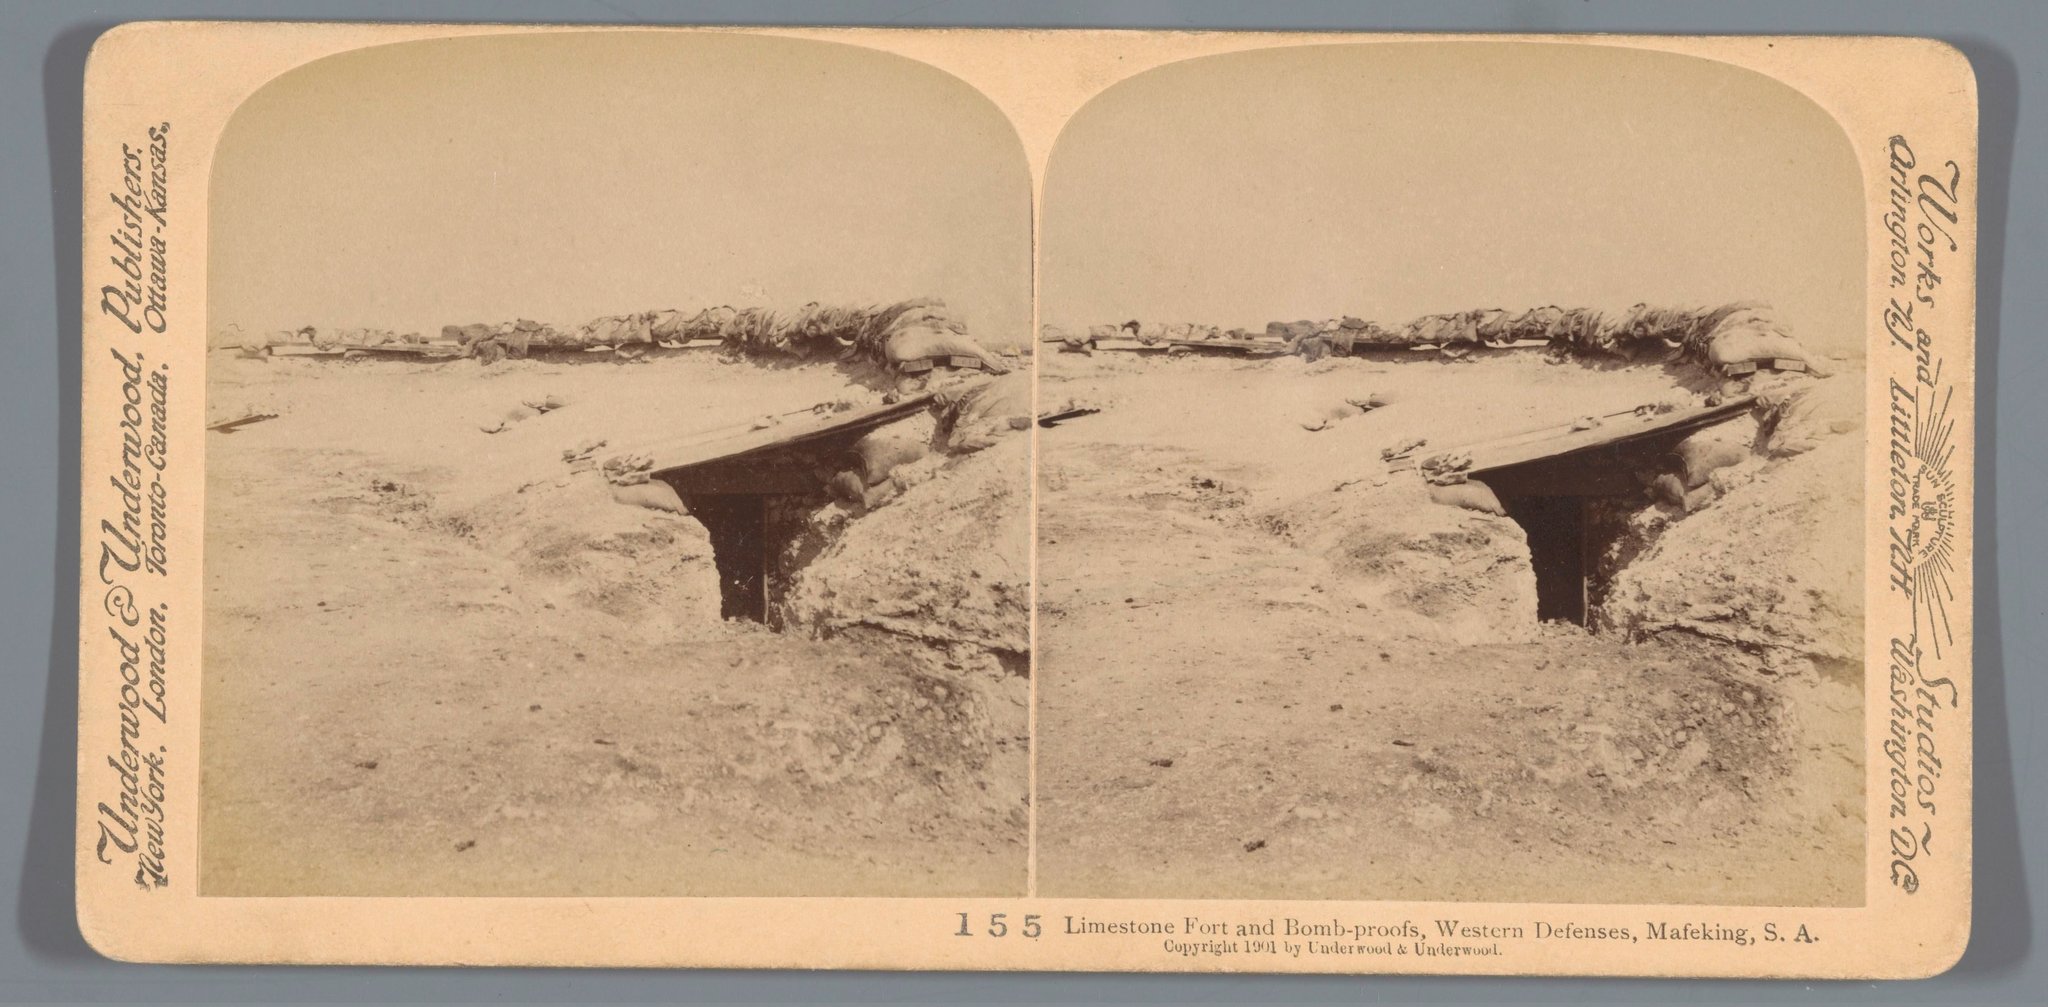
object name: stereograph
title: Limestone Fort and Bomb-proofs, Western Defenses, Mafeking, S.A.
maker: Anonymous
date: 1901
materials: cardboard, paper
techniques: albumen print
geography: new york city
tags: defensive measures (military)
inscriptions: copyright notice: ‘Copyright 1901 by Underwood & Underwood.’, number: ‘155’, inscription, inscription: ‘Works and Studios ~/ Arlington, N.J. Littleton, N.H. Washington, D.C.’